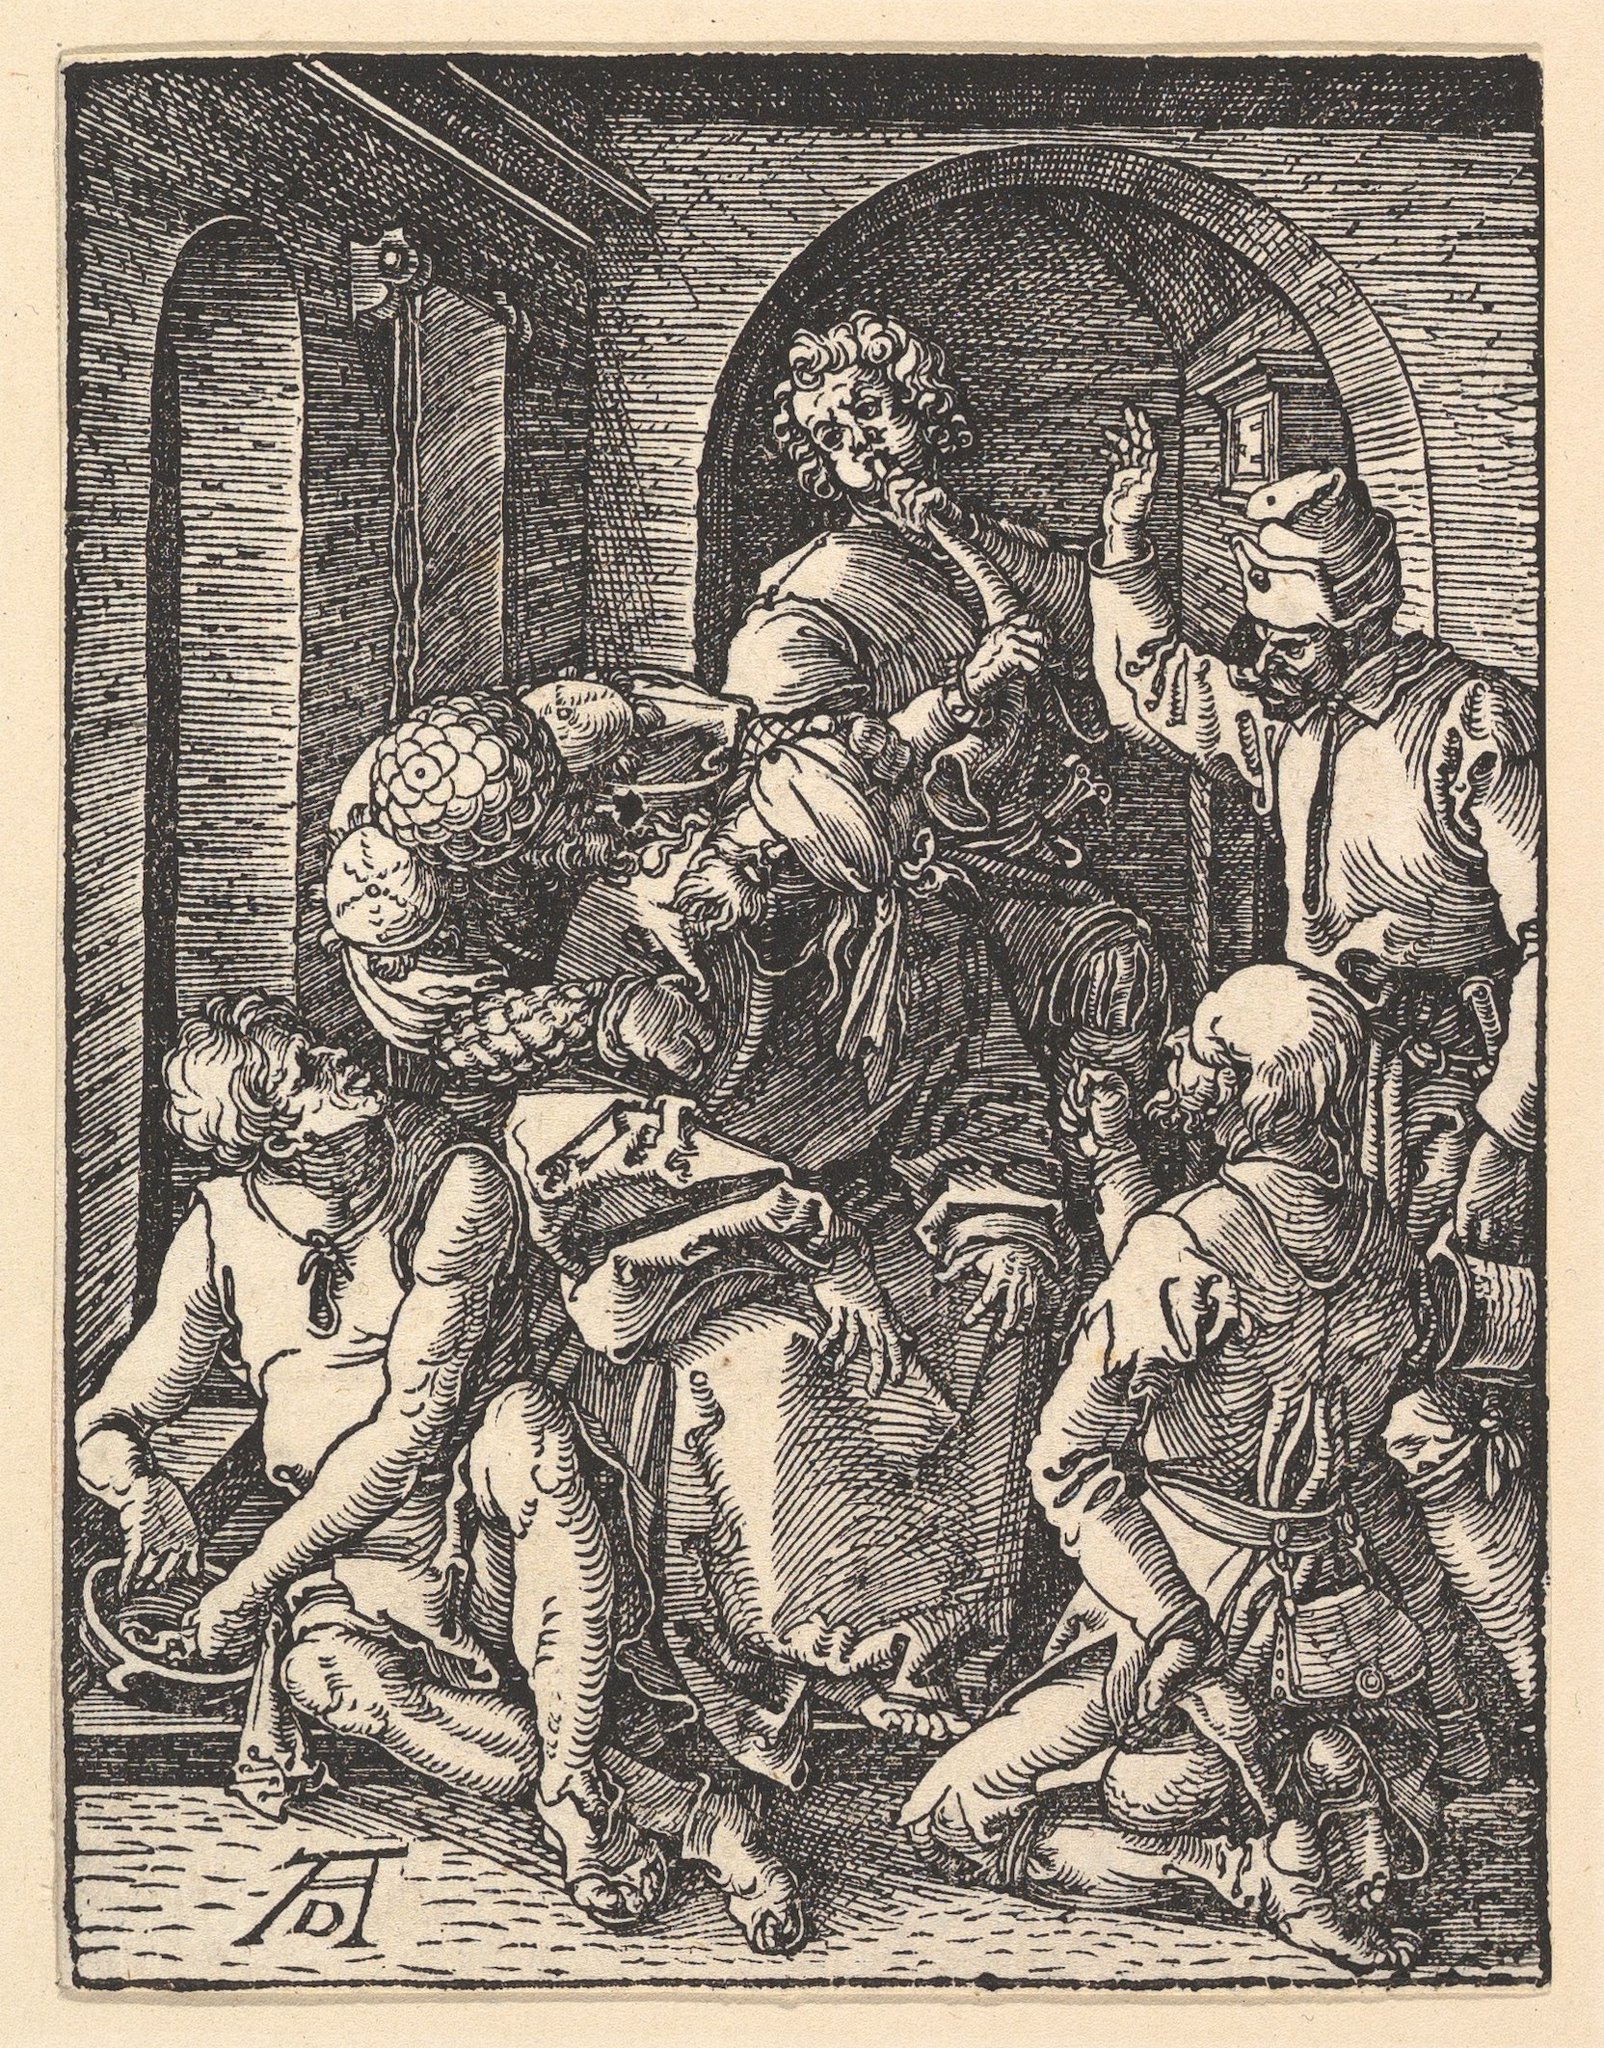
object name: print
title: The Mocking of Christ, from "The Small Passion"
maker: albrecht dürer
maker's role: artist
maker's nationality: german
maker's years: 1471-1528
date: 1508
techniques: woodcut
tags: men,christ